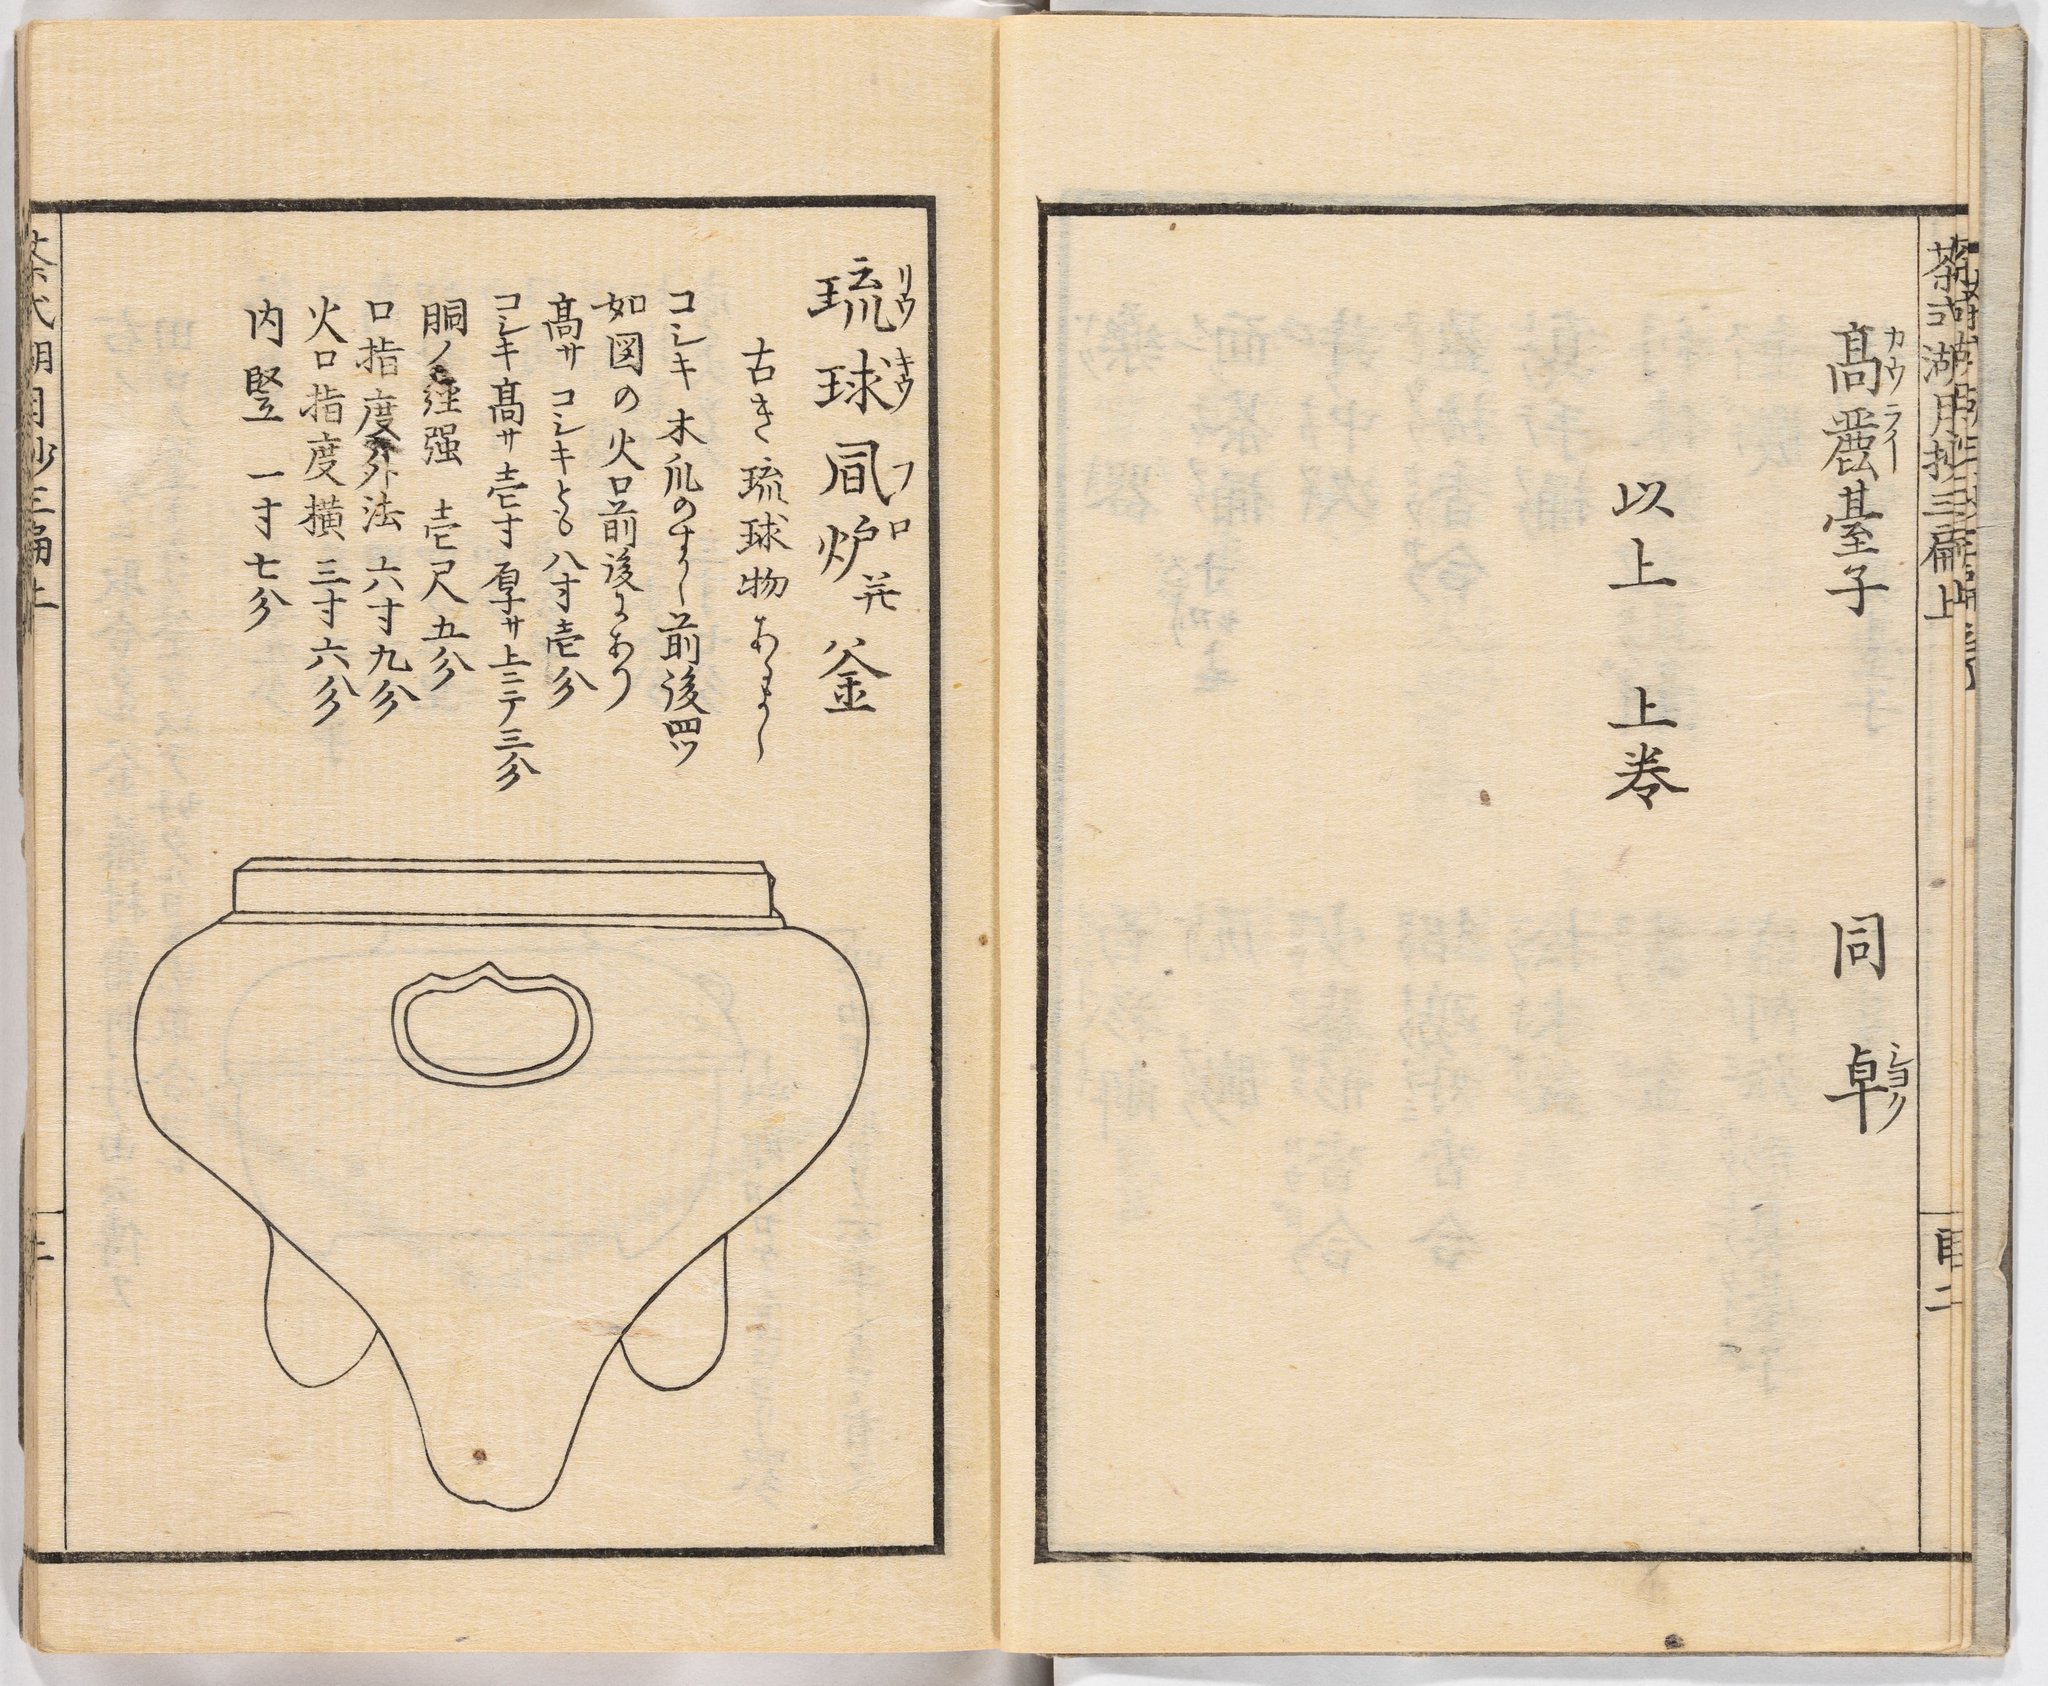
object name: illustrated book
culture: japanese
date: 1893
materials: ink, paper